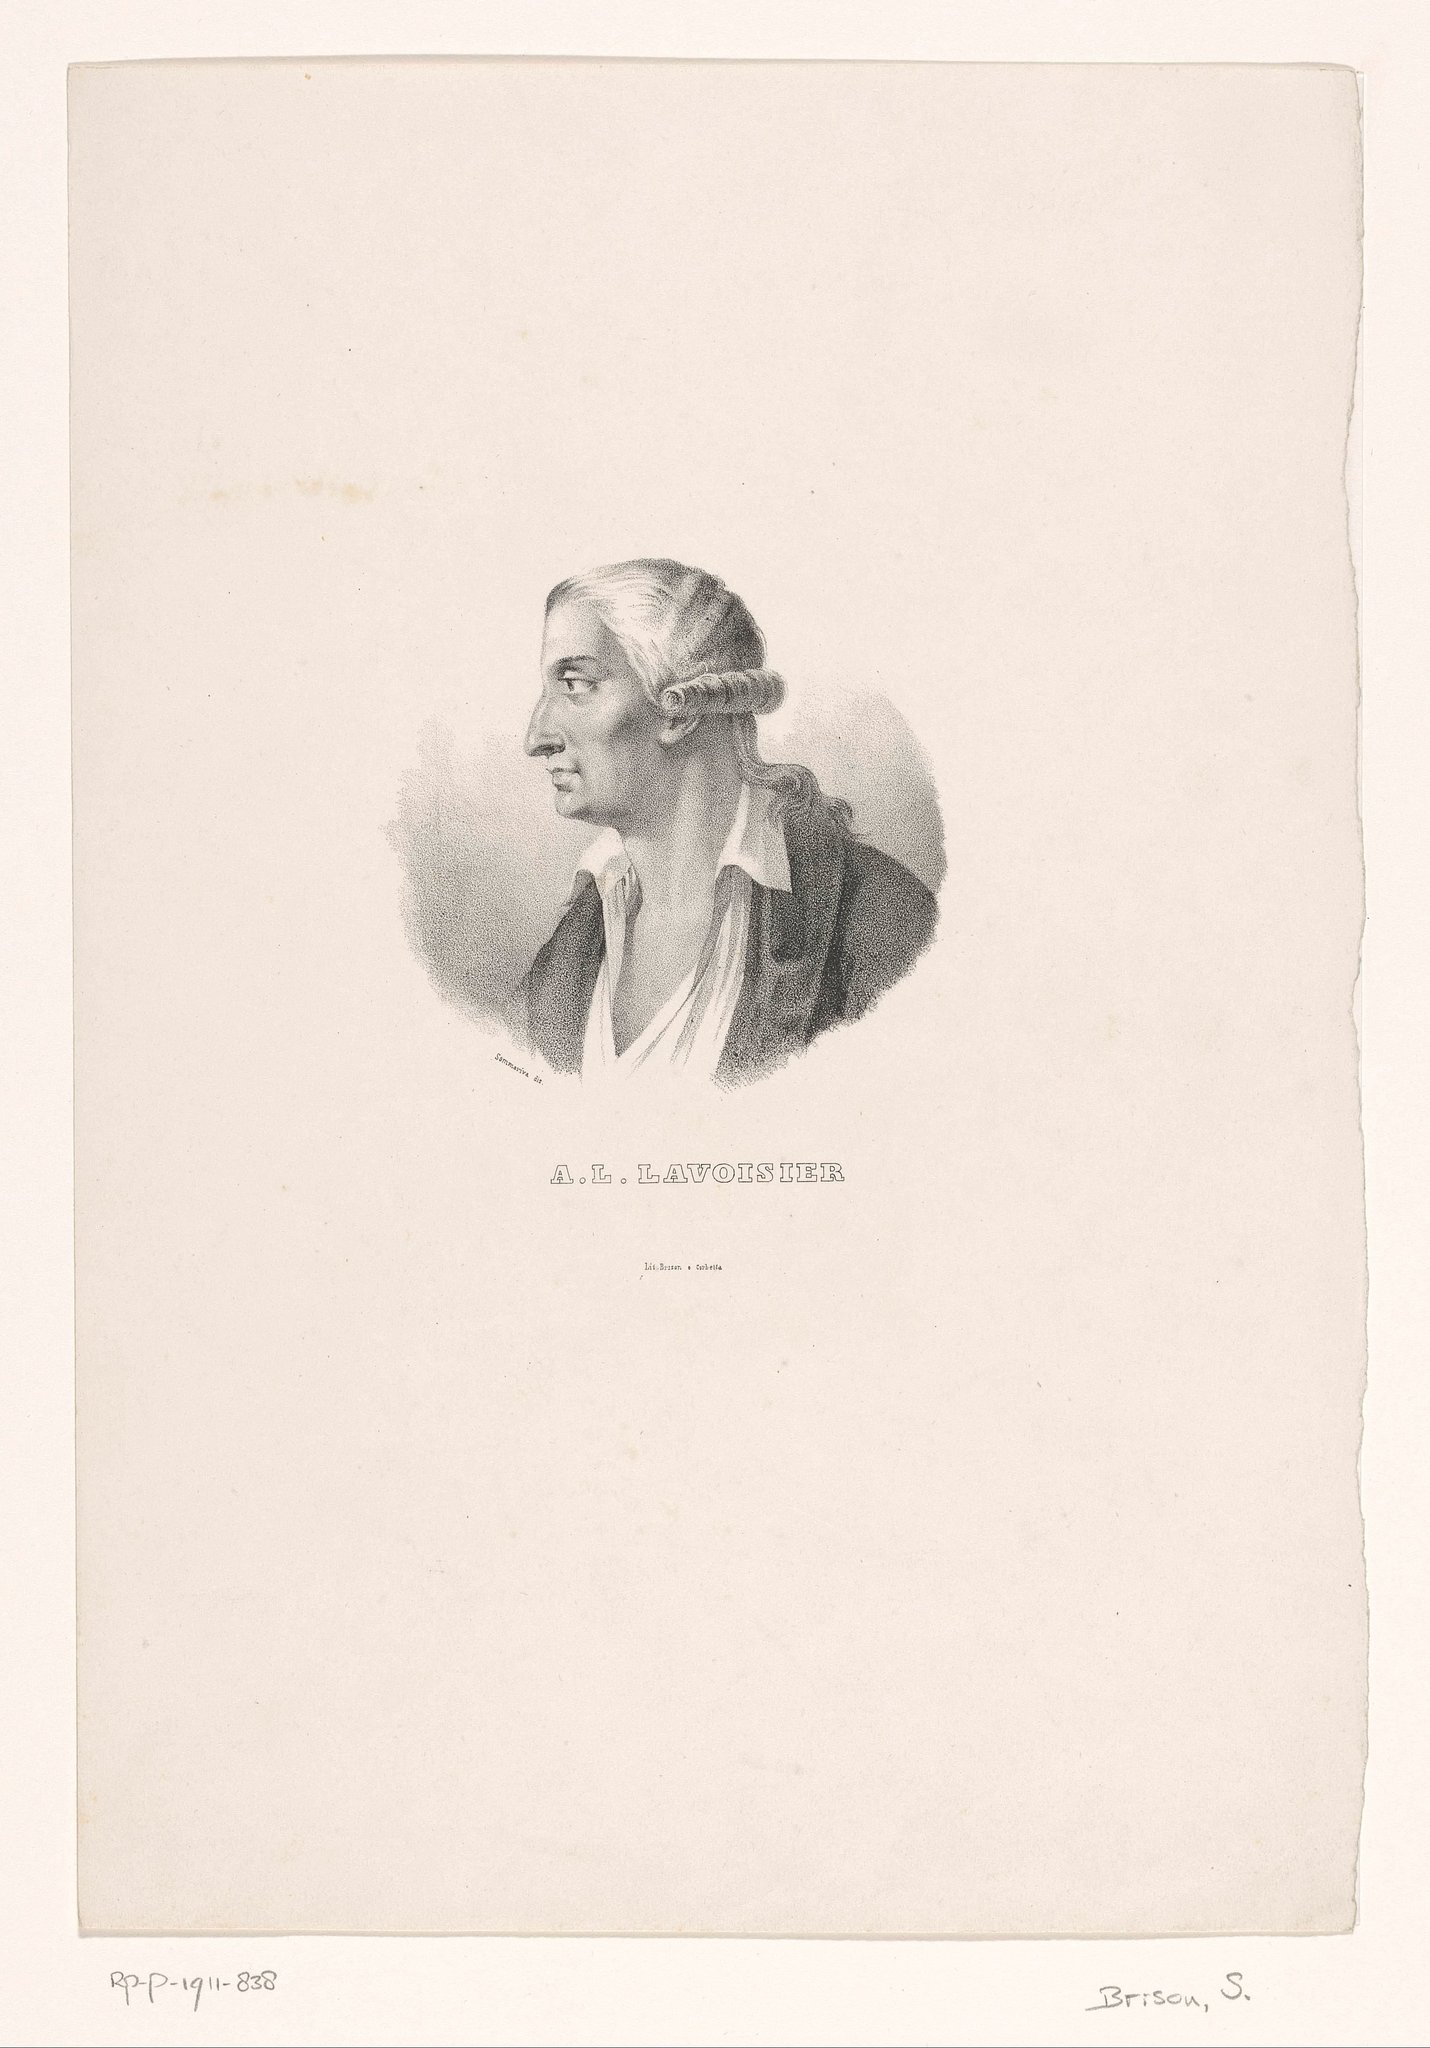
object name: print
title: Portret van scheikundige Antoine Lavoisier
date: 1825-1848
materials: paper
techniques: lithograph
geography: italy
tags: historical persons, science and technology (+ portrait of scholar, scientist)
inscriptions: collector's mark: Lugt 2228